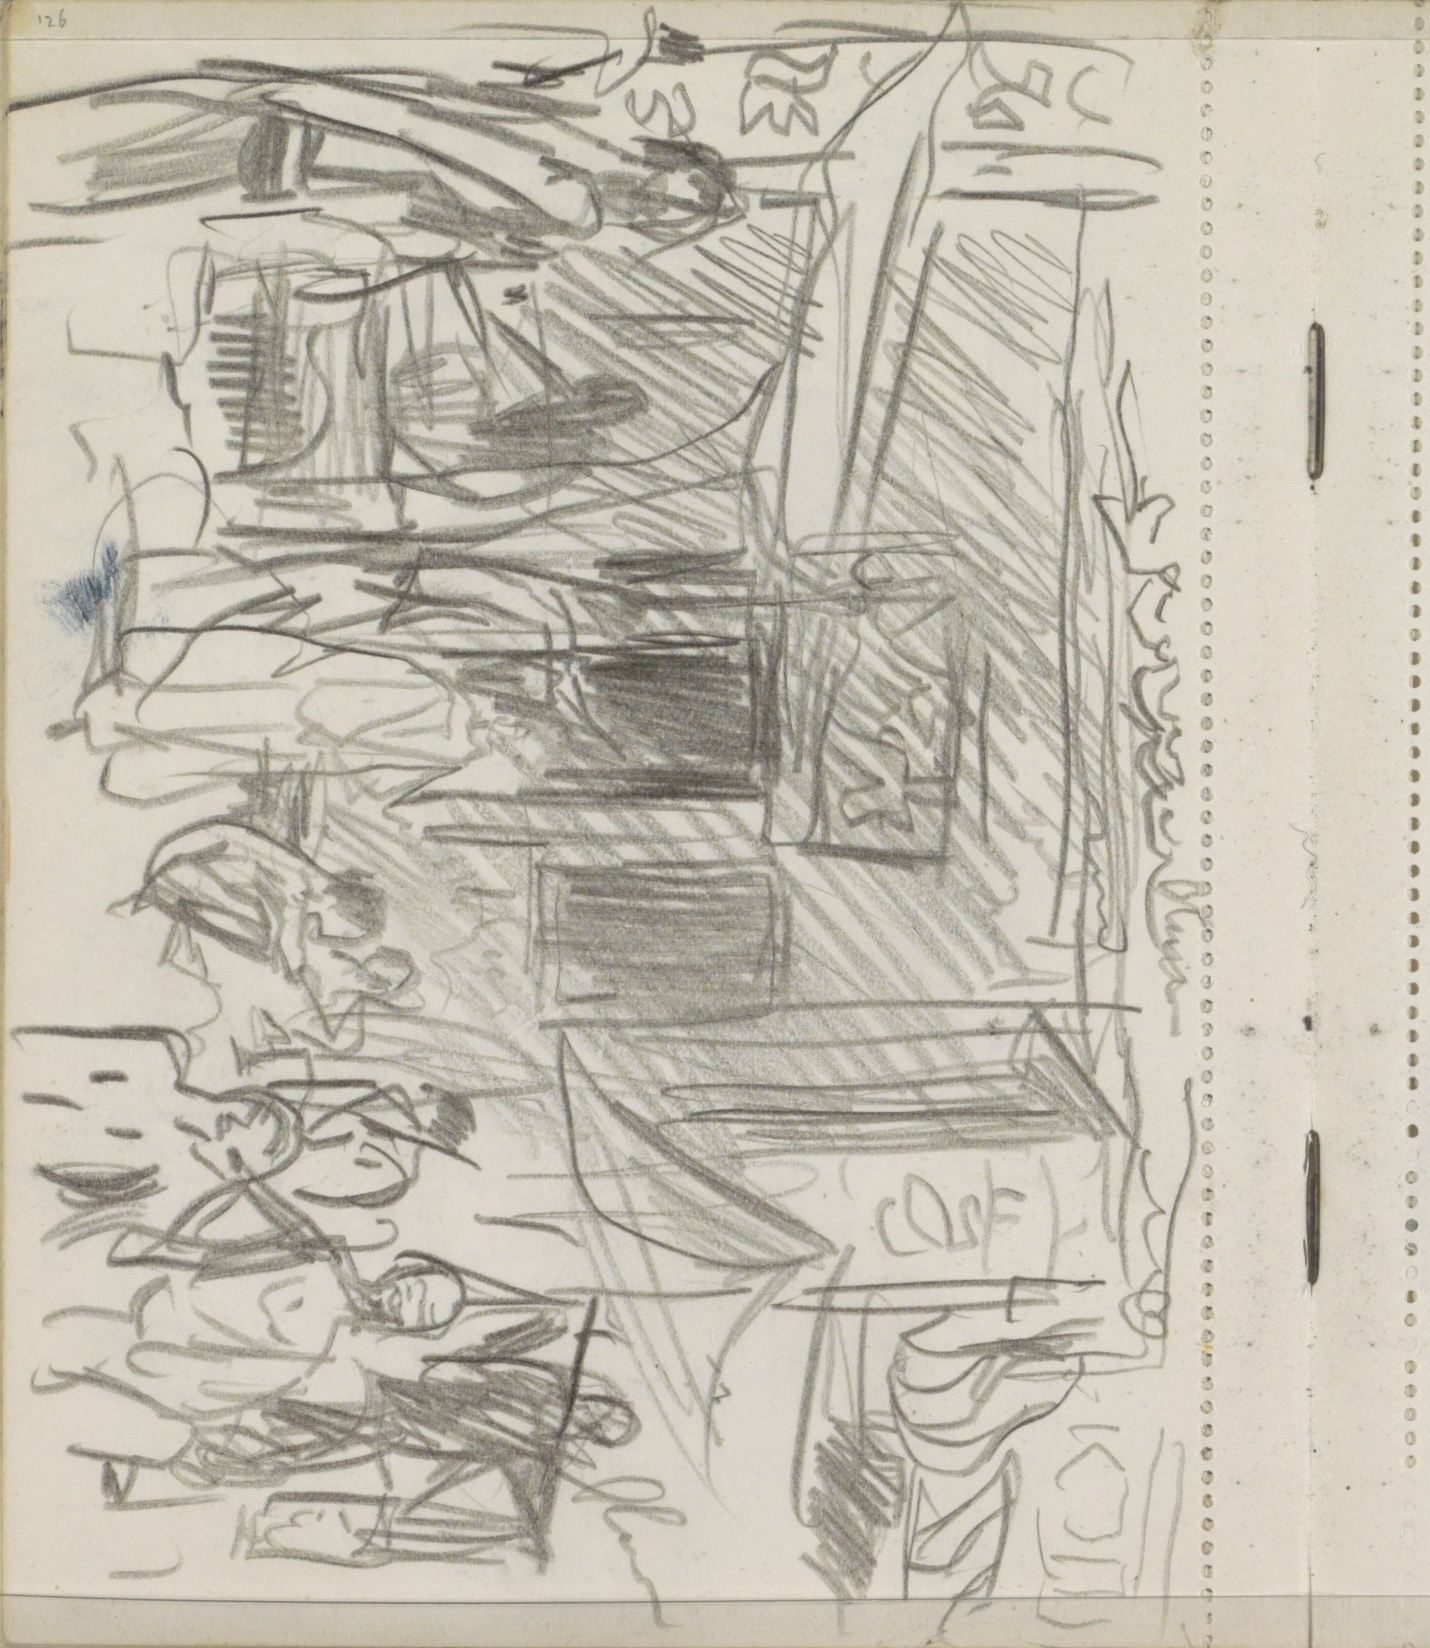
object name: sketchbook leaf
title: Straat met figuren, een marktkraam en een waterdrager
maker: marius bauer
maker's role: draughtsman, print maker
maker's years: 1867-1932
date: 1925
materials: chalk, paper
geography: indonesia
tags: asiatic races and peoples, carrying something, stall, booth (~ market), street (+ city(-scape) with figures, staffage)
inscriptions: kleurnotitie, handgeschreven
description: Pagina 126 uit een schetsboek met 67 bladen.